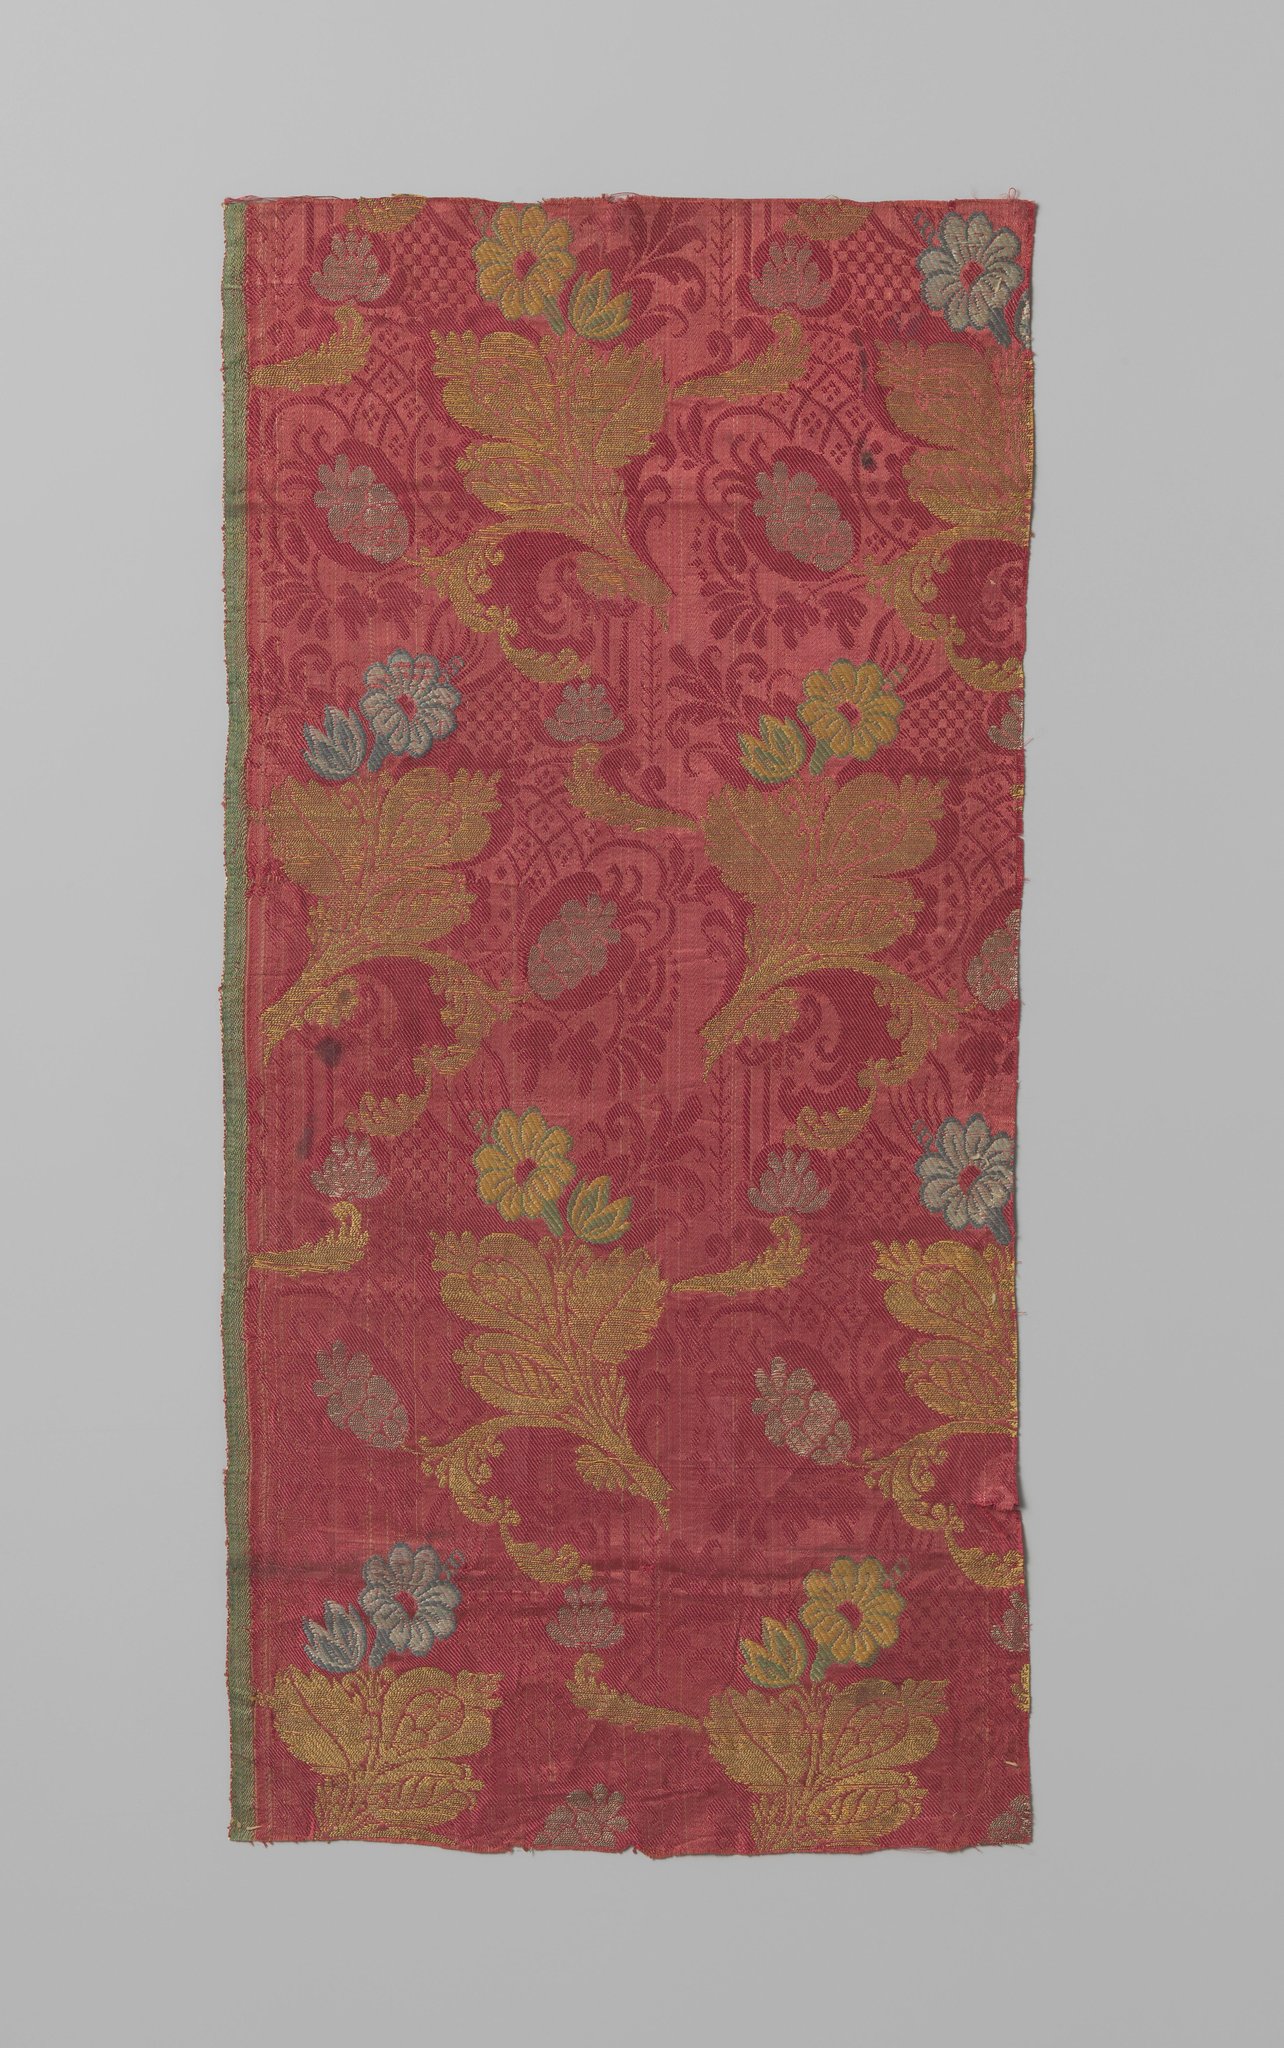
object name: fragment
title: Damast, fragment, van rood satijn met bloemen van groene, gele, blauwe, paarse en witte zijde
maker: Anonymous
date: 1725-1750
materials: gold thread, silk, thread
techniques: brocade, damask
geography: france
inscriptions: label: ‘cat. 194’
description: Damast, fragment, van rood satijn met bloemen van groene, gele, blauwe, paarse en witte zijde, verder figuren van goud- en zilverdraad. Duitsland (volgens inventarisboek). Opmerking: Zelfkant; 0.7 cm (2 kantdraden), keper (afwijkende kleur).